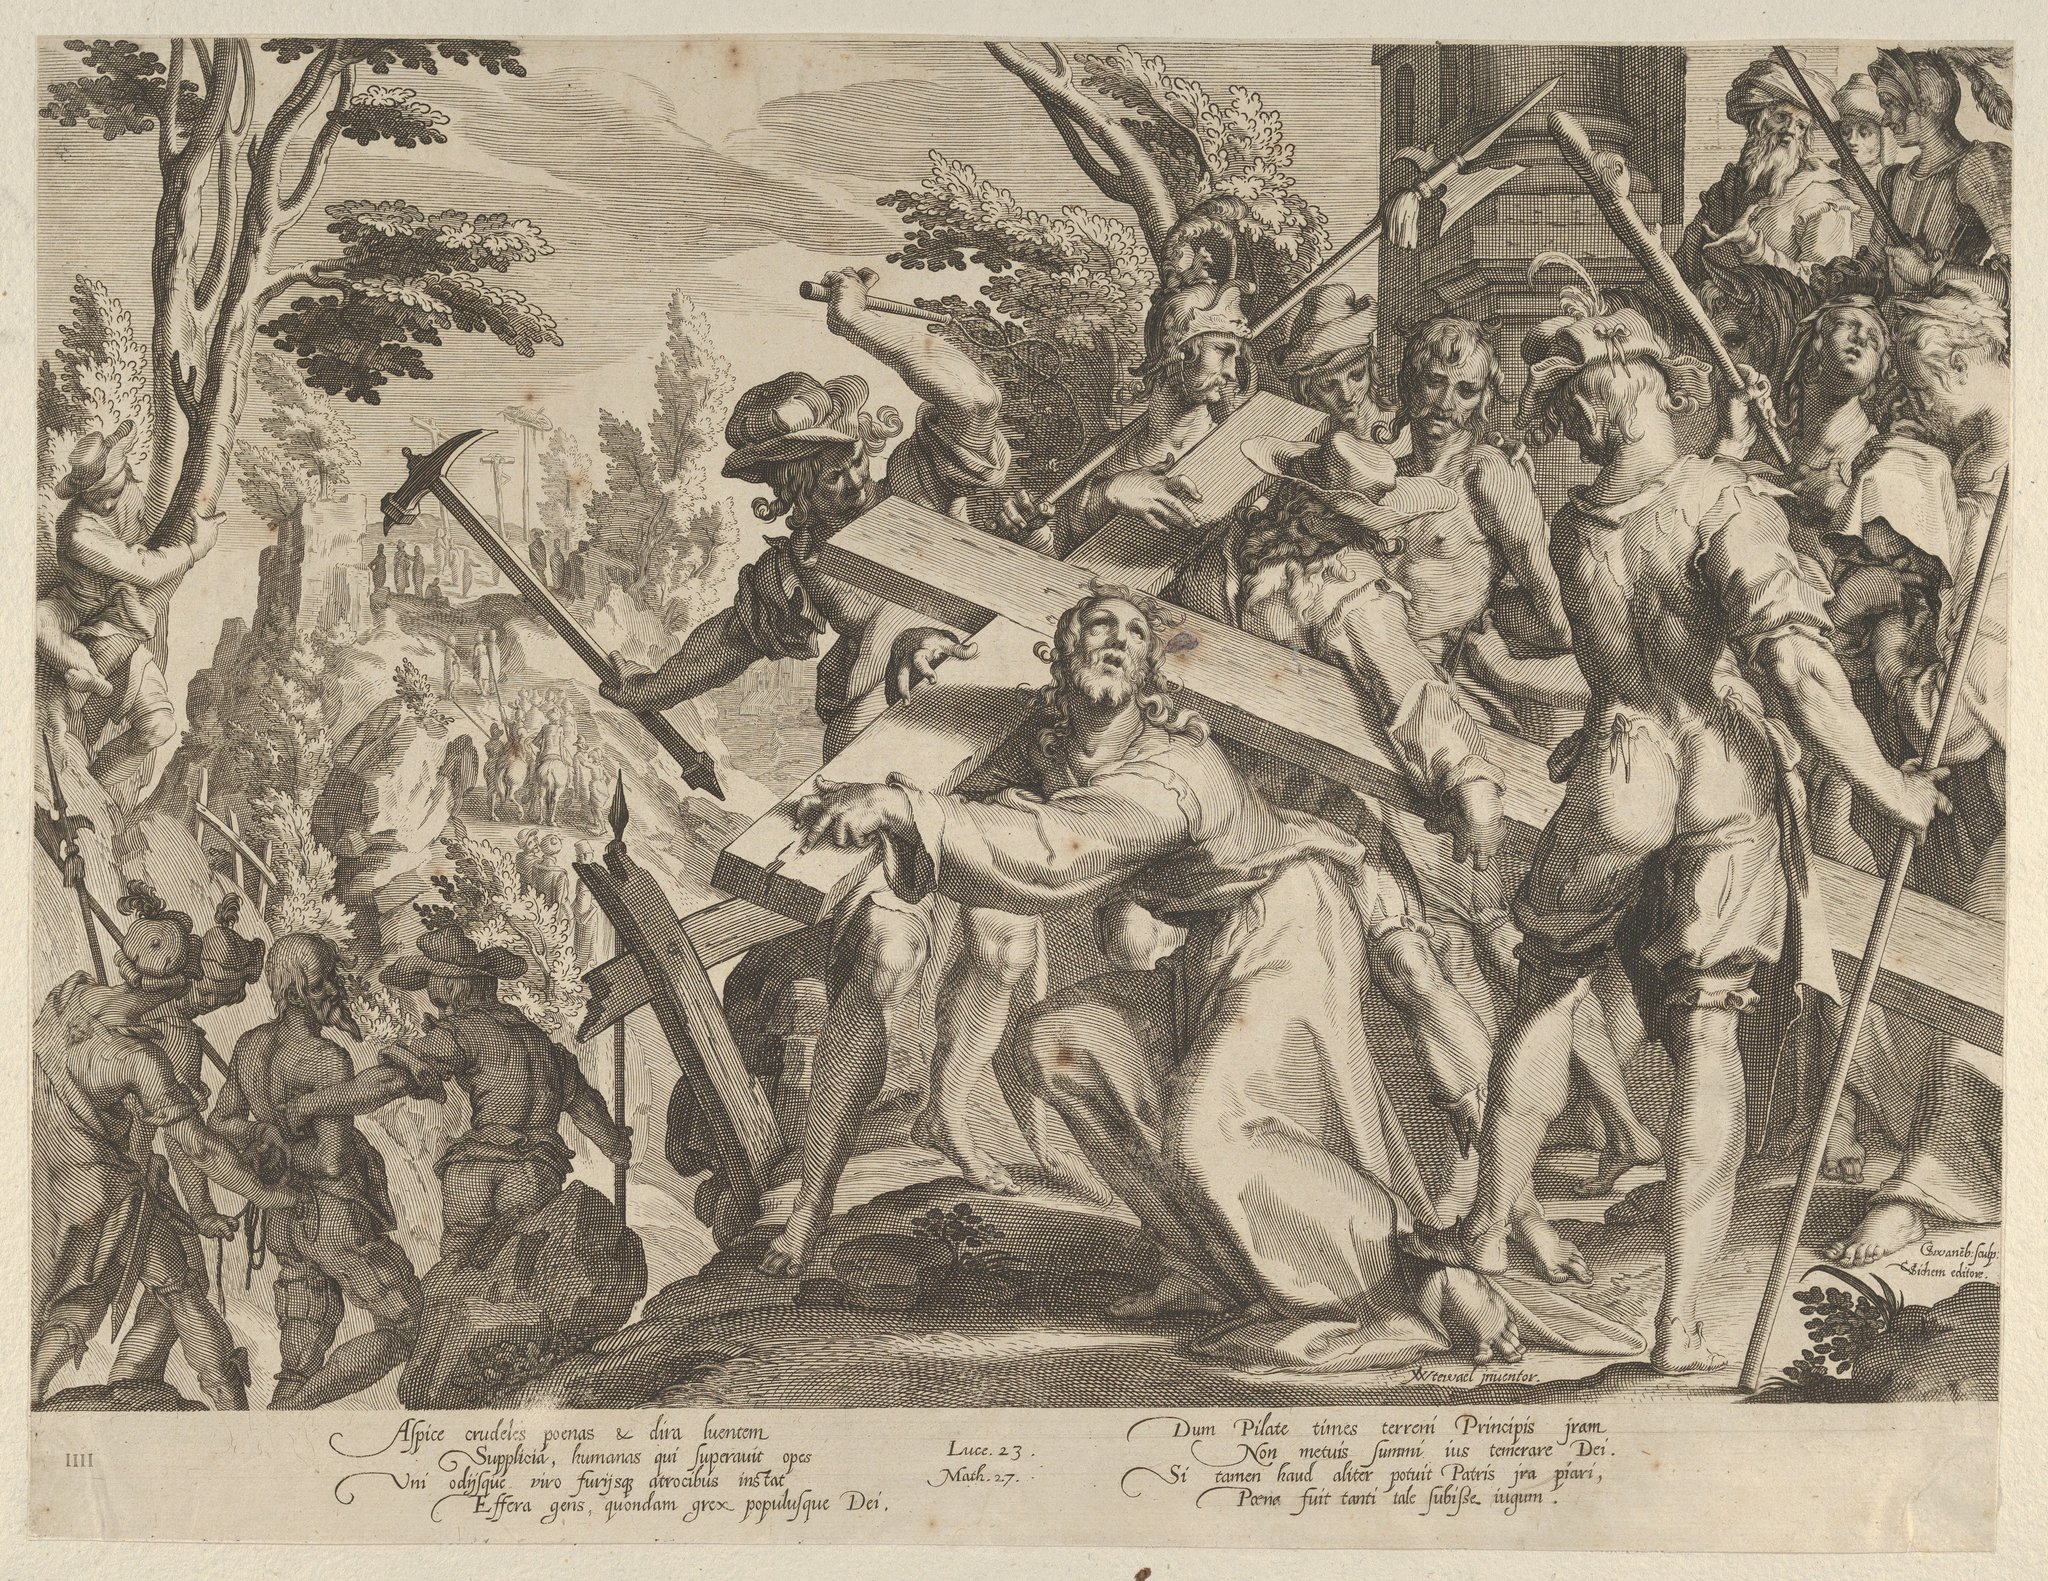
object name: print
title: Christ Carrying the Cross, plate 4 from "Thronus Justitiae, tredecim pulcherrimus tabulis..."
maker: willem van swanenburg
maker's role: artist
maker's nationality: netherlandish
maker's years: 1581-1612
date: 1605-1606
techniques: engraving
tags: soldiers,men,christ,cross,punishment